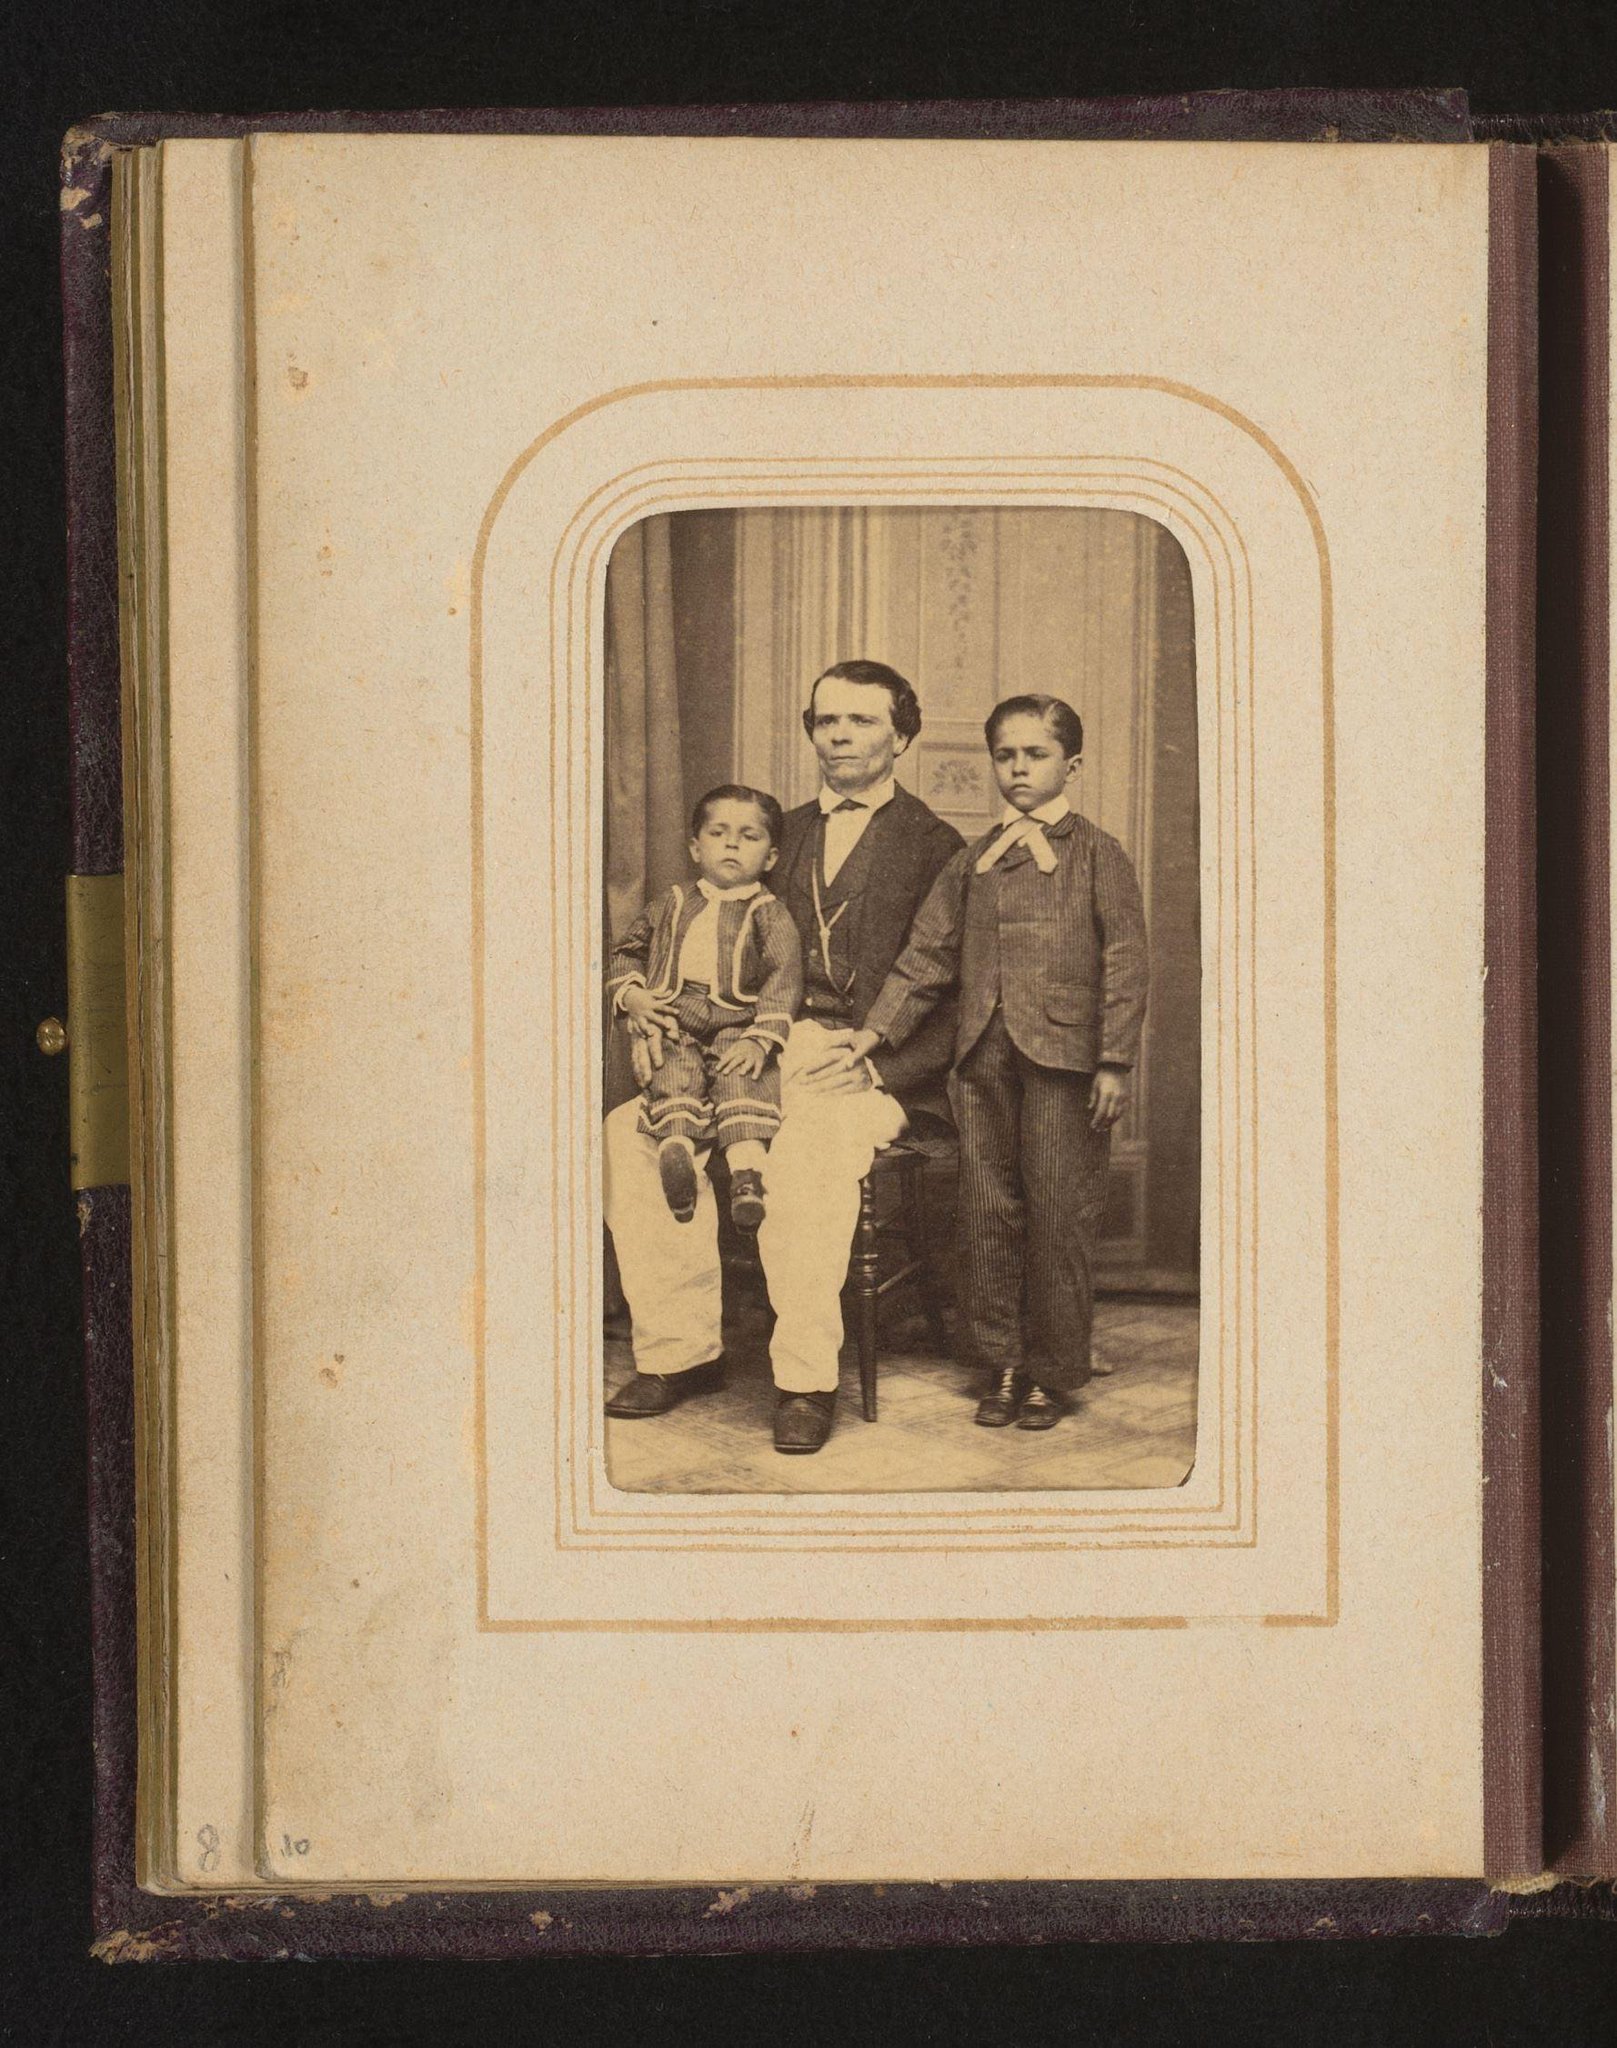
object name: album leaf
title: Familieportret met een vader en twee zoons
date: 1860-1900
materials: cardboard, photographic support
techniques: albumen print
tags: father and child(ren), man and child(ren) (family group)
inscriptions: inscription: ‘Galeria Fotografica/ De Leon’, annotation: ‘Para Isabelita’